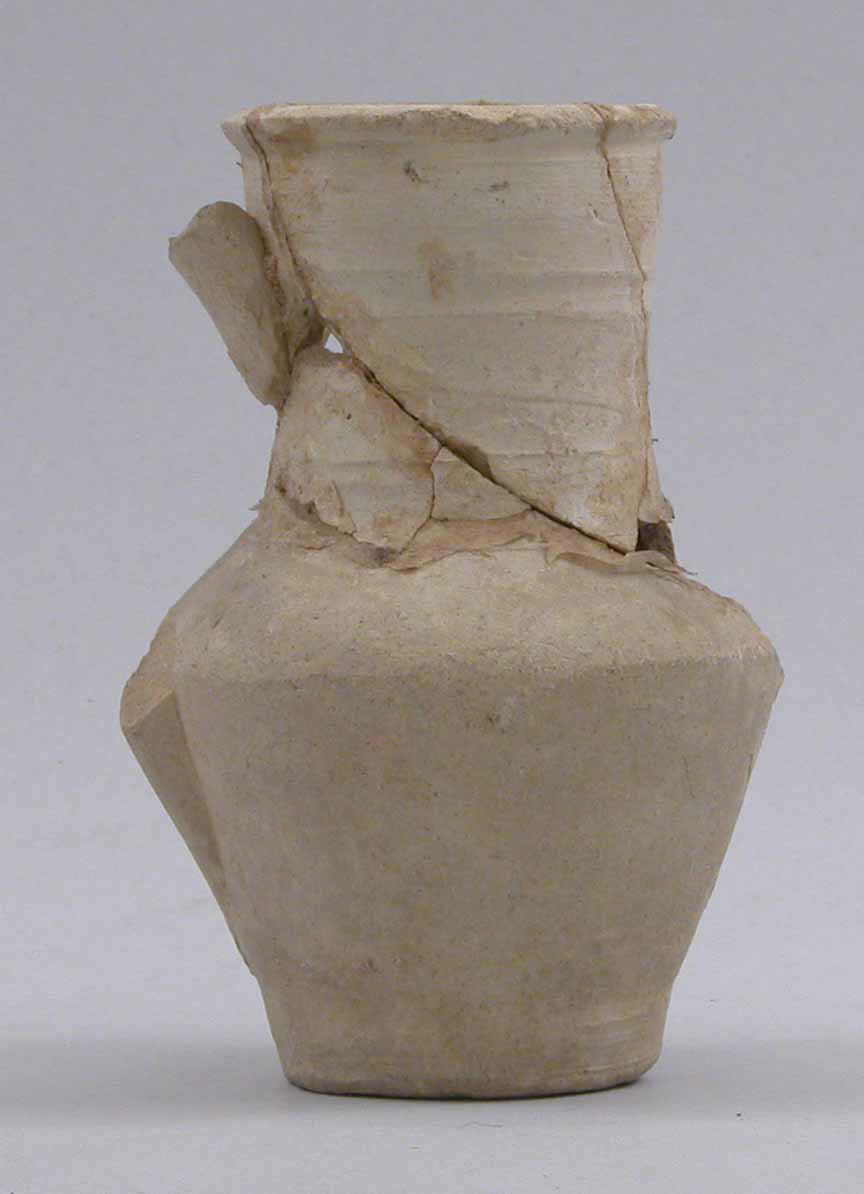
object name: jug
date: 801-1000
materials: earthenware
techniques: incising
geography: iran